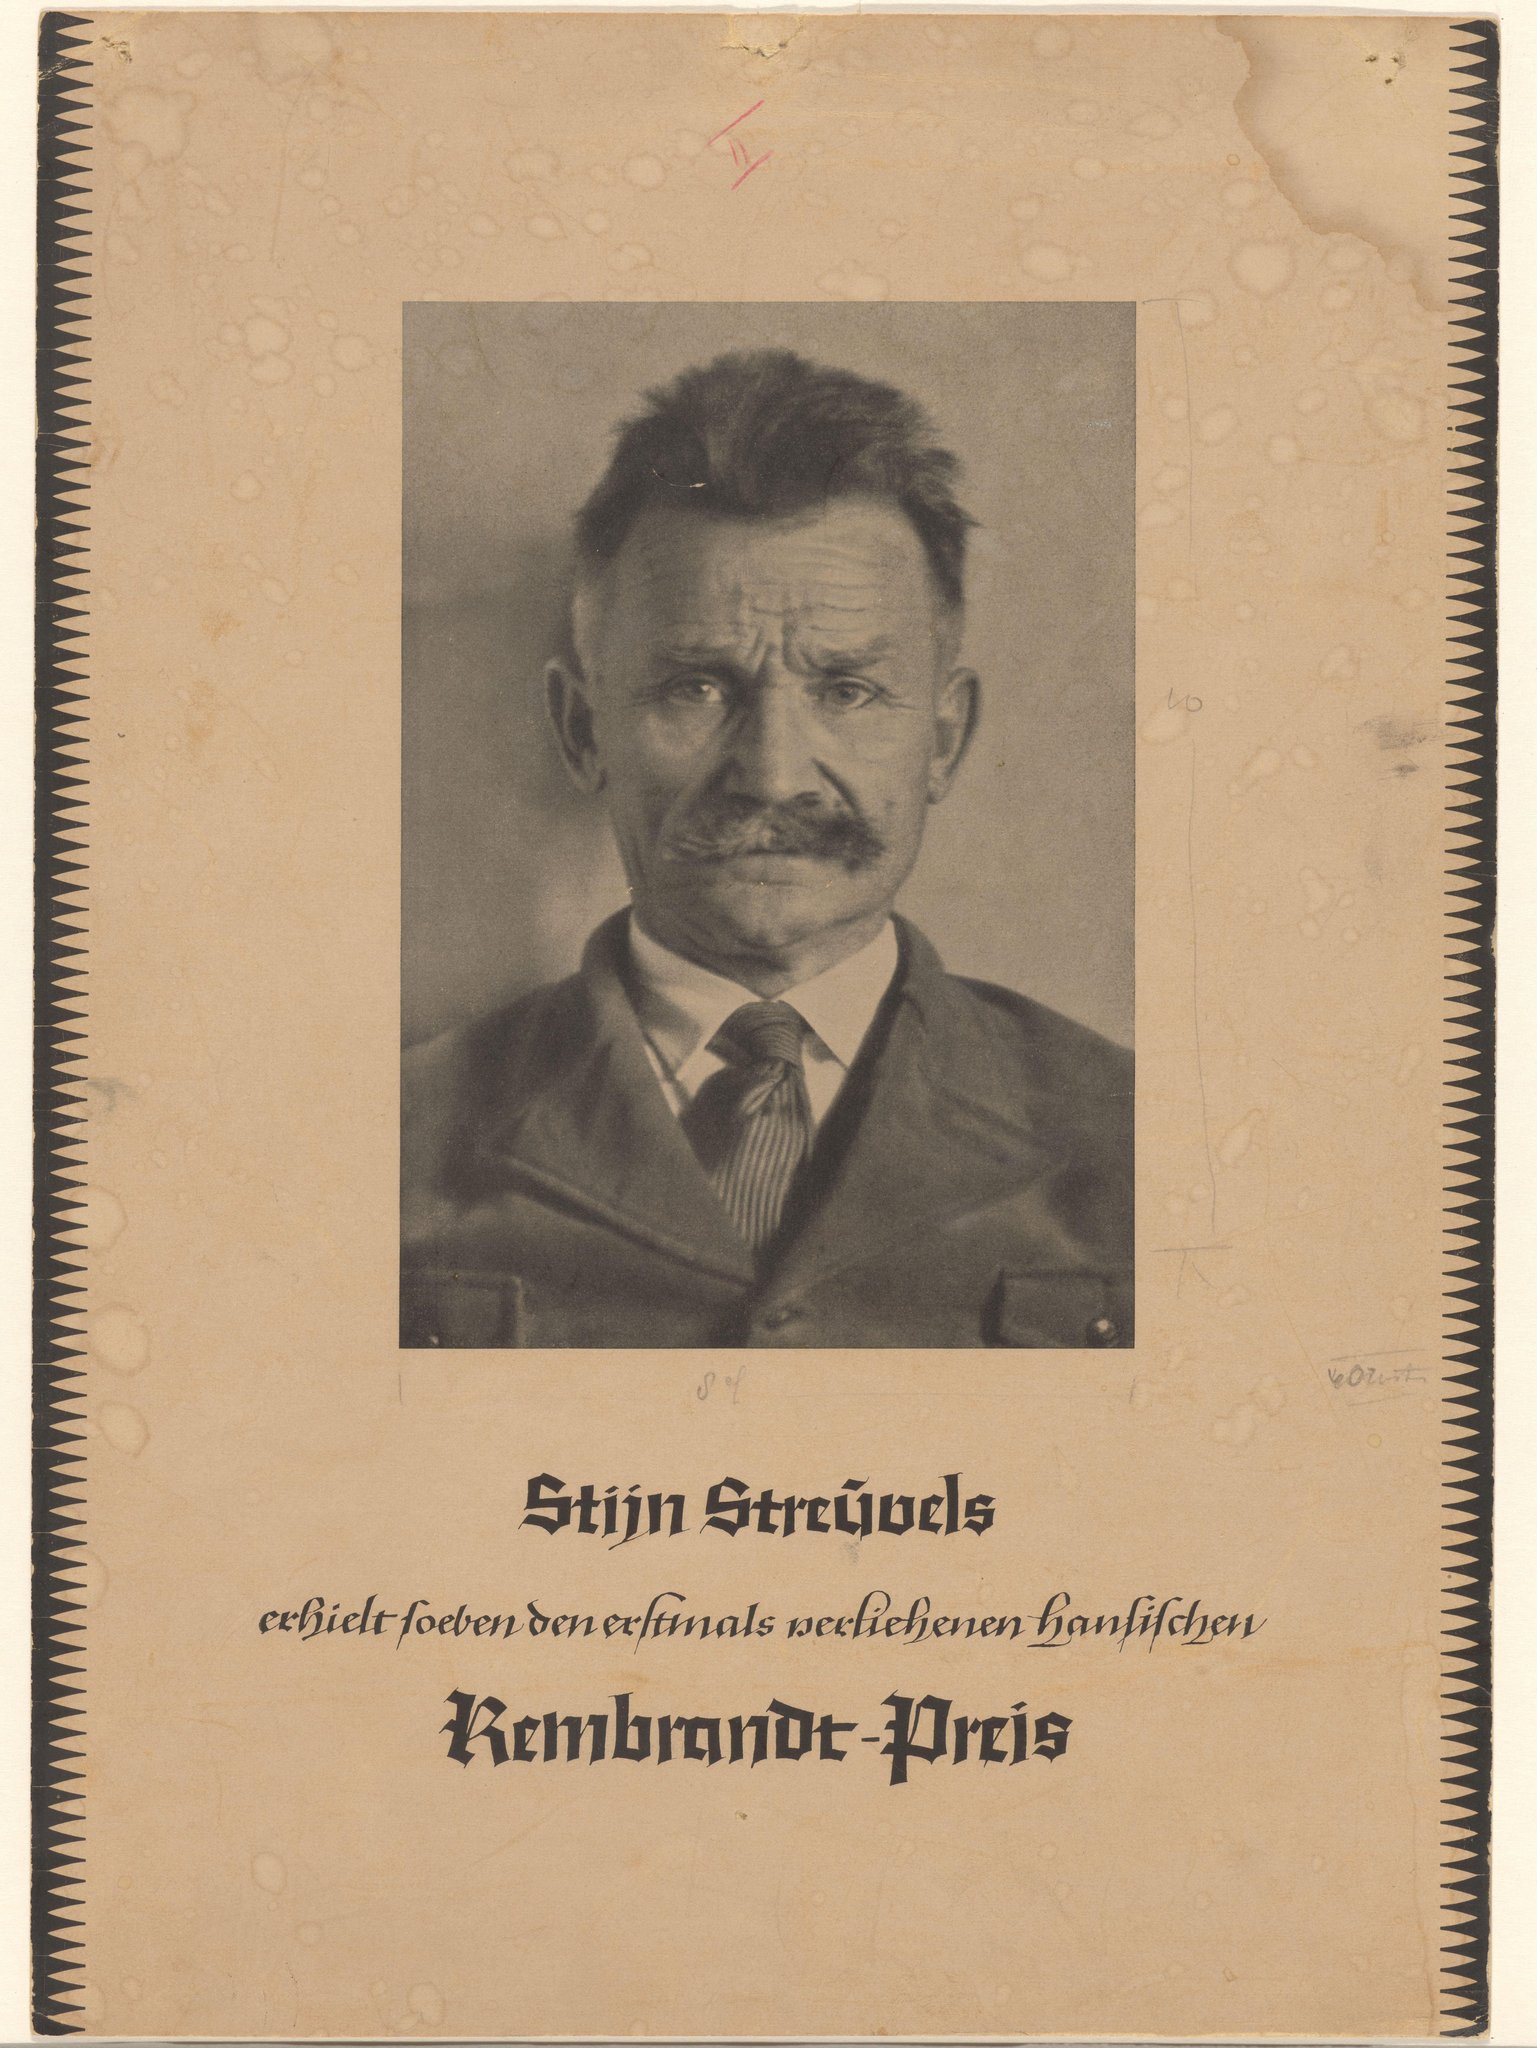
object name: photomechanical print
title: Portret van Stijn Streuvels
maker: Anonymous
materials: paper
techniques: autotype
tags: stijn streuvels, historical persons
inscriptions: number: ‘II’, :, collector's mark: Lugt 2228a, inscription: ‘Stijn Streuvels/ erhielt soeben den erstmals verliehenen/ Rembrandt-Preis’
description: Onderaan de vermelding dat Streuvels de Rembrandtprijs heeft ontvangen, die voor het eerst in uitgereikt in de Hanze.